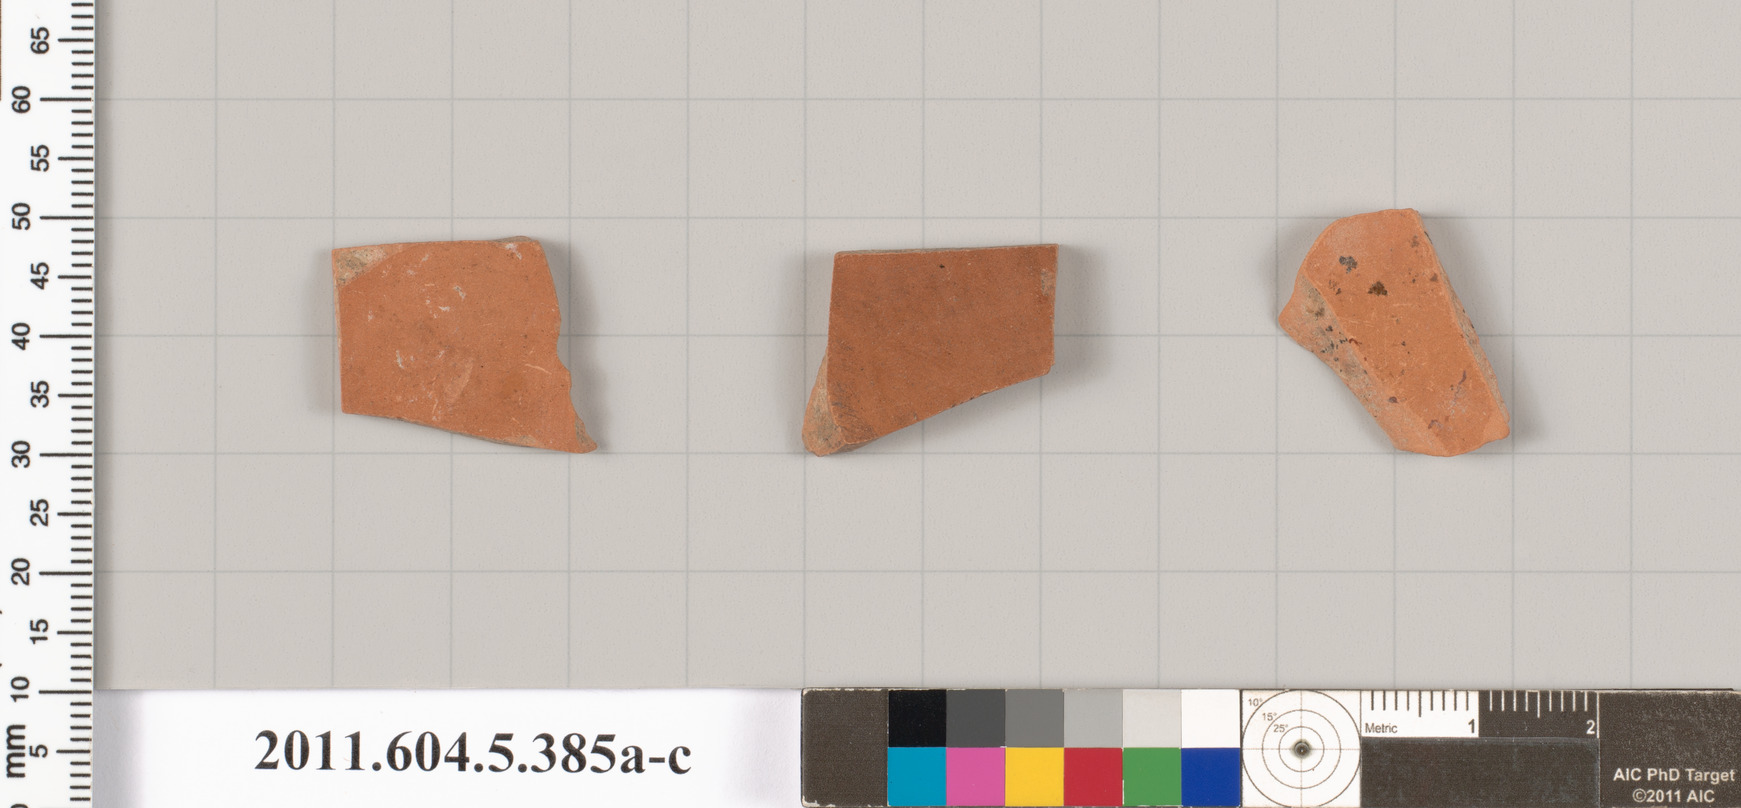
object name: kylix fragment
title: Terracotta fragments of kylikes (drinking cups)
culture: greek, attic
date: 600-401 BCE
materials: terracotta